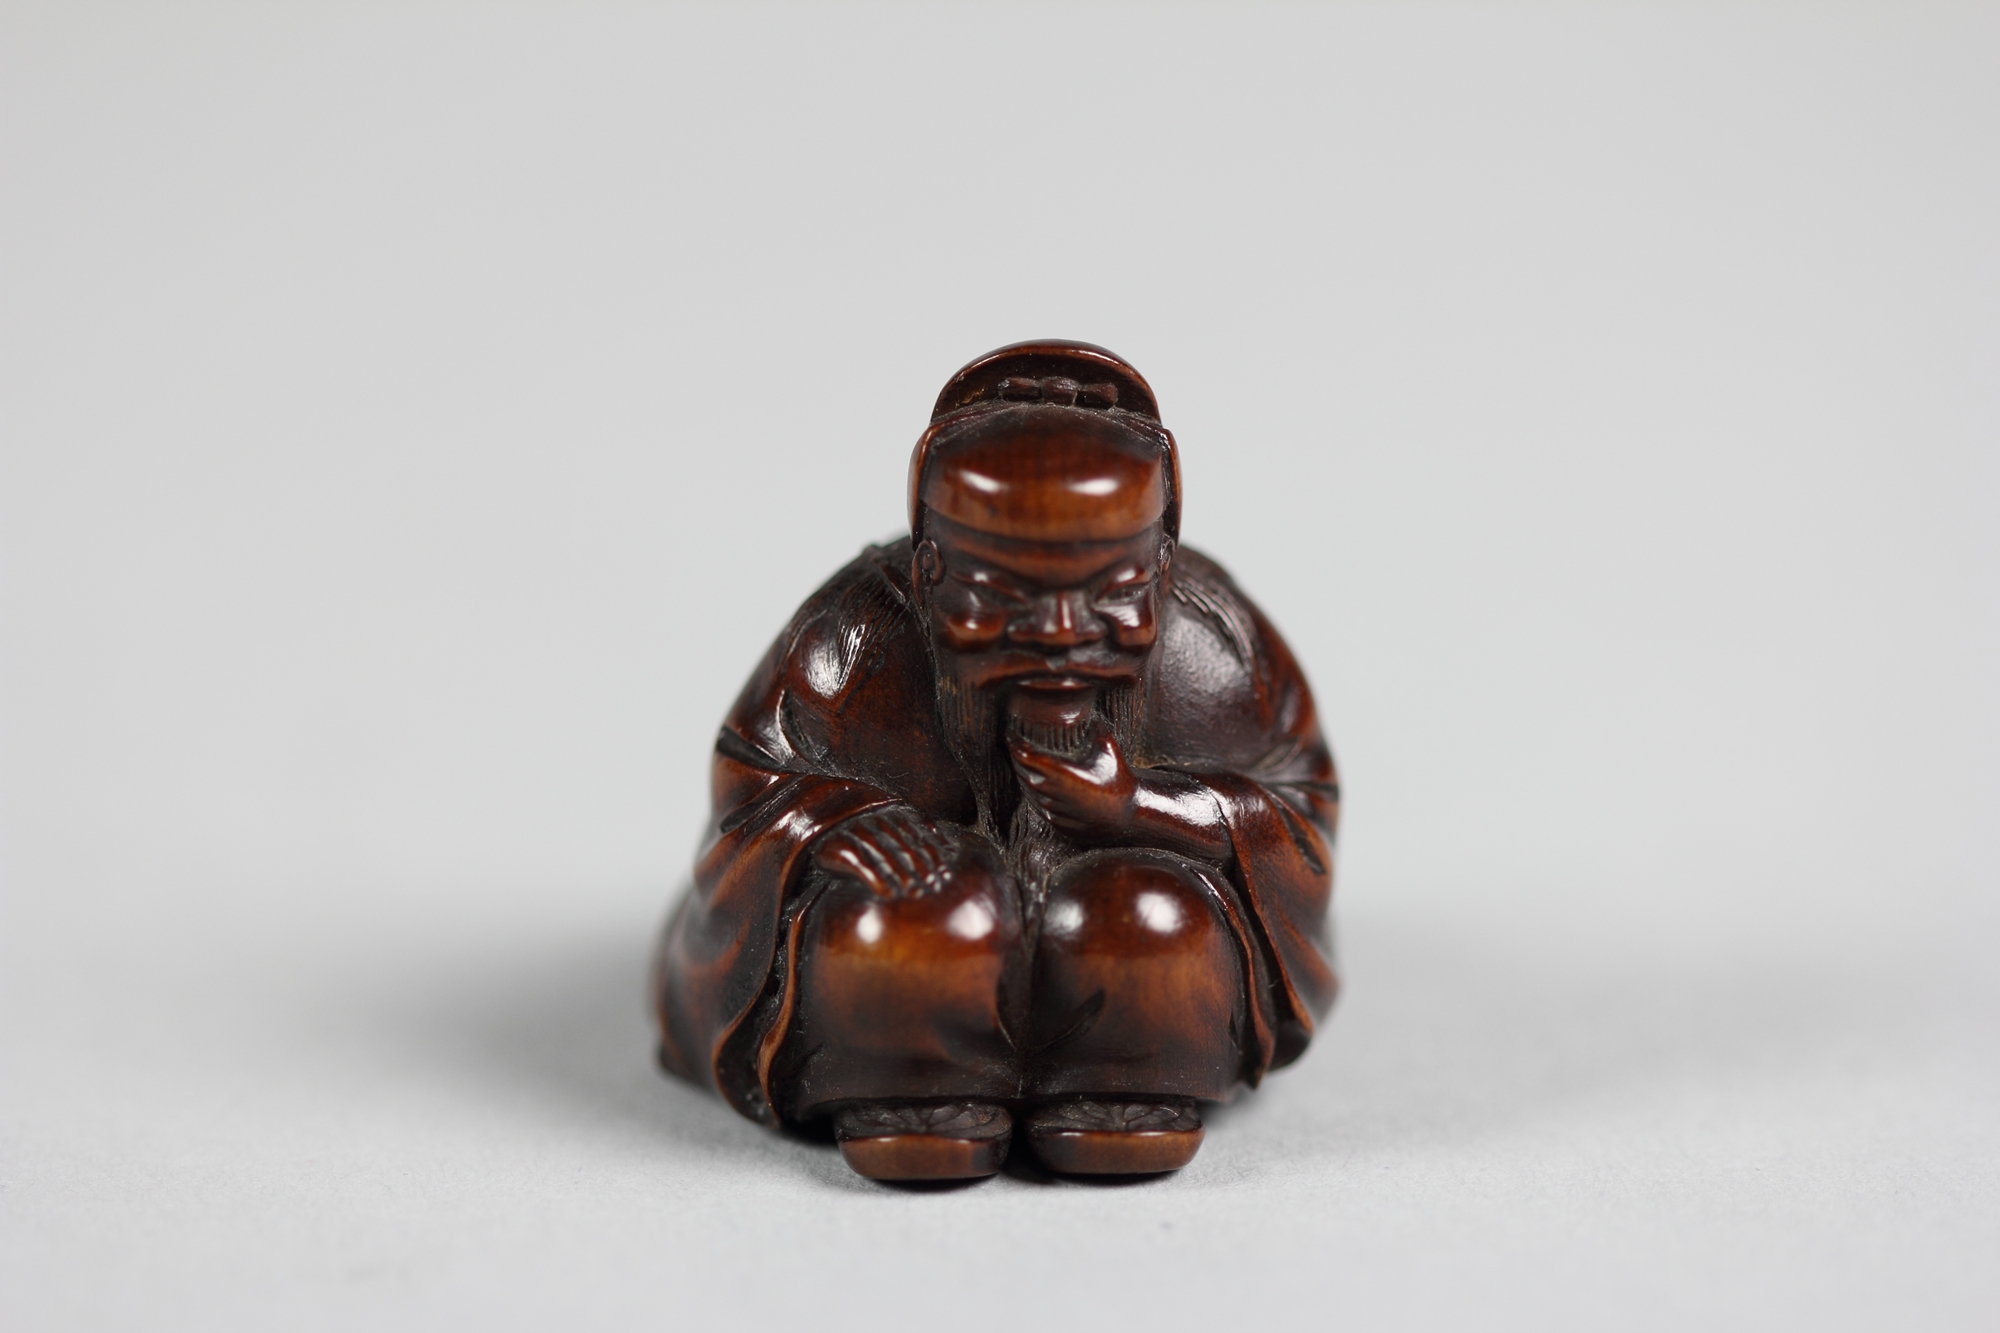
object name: netsuke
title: Netsuke of Seated Figure of an Old Man with Backpack Containing a Mask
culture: japanese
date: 1701-1800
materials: wood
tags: men